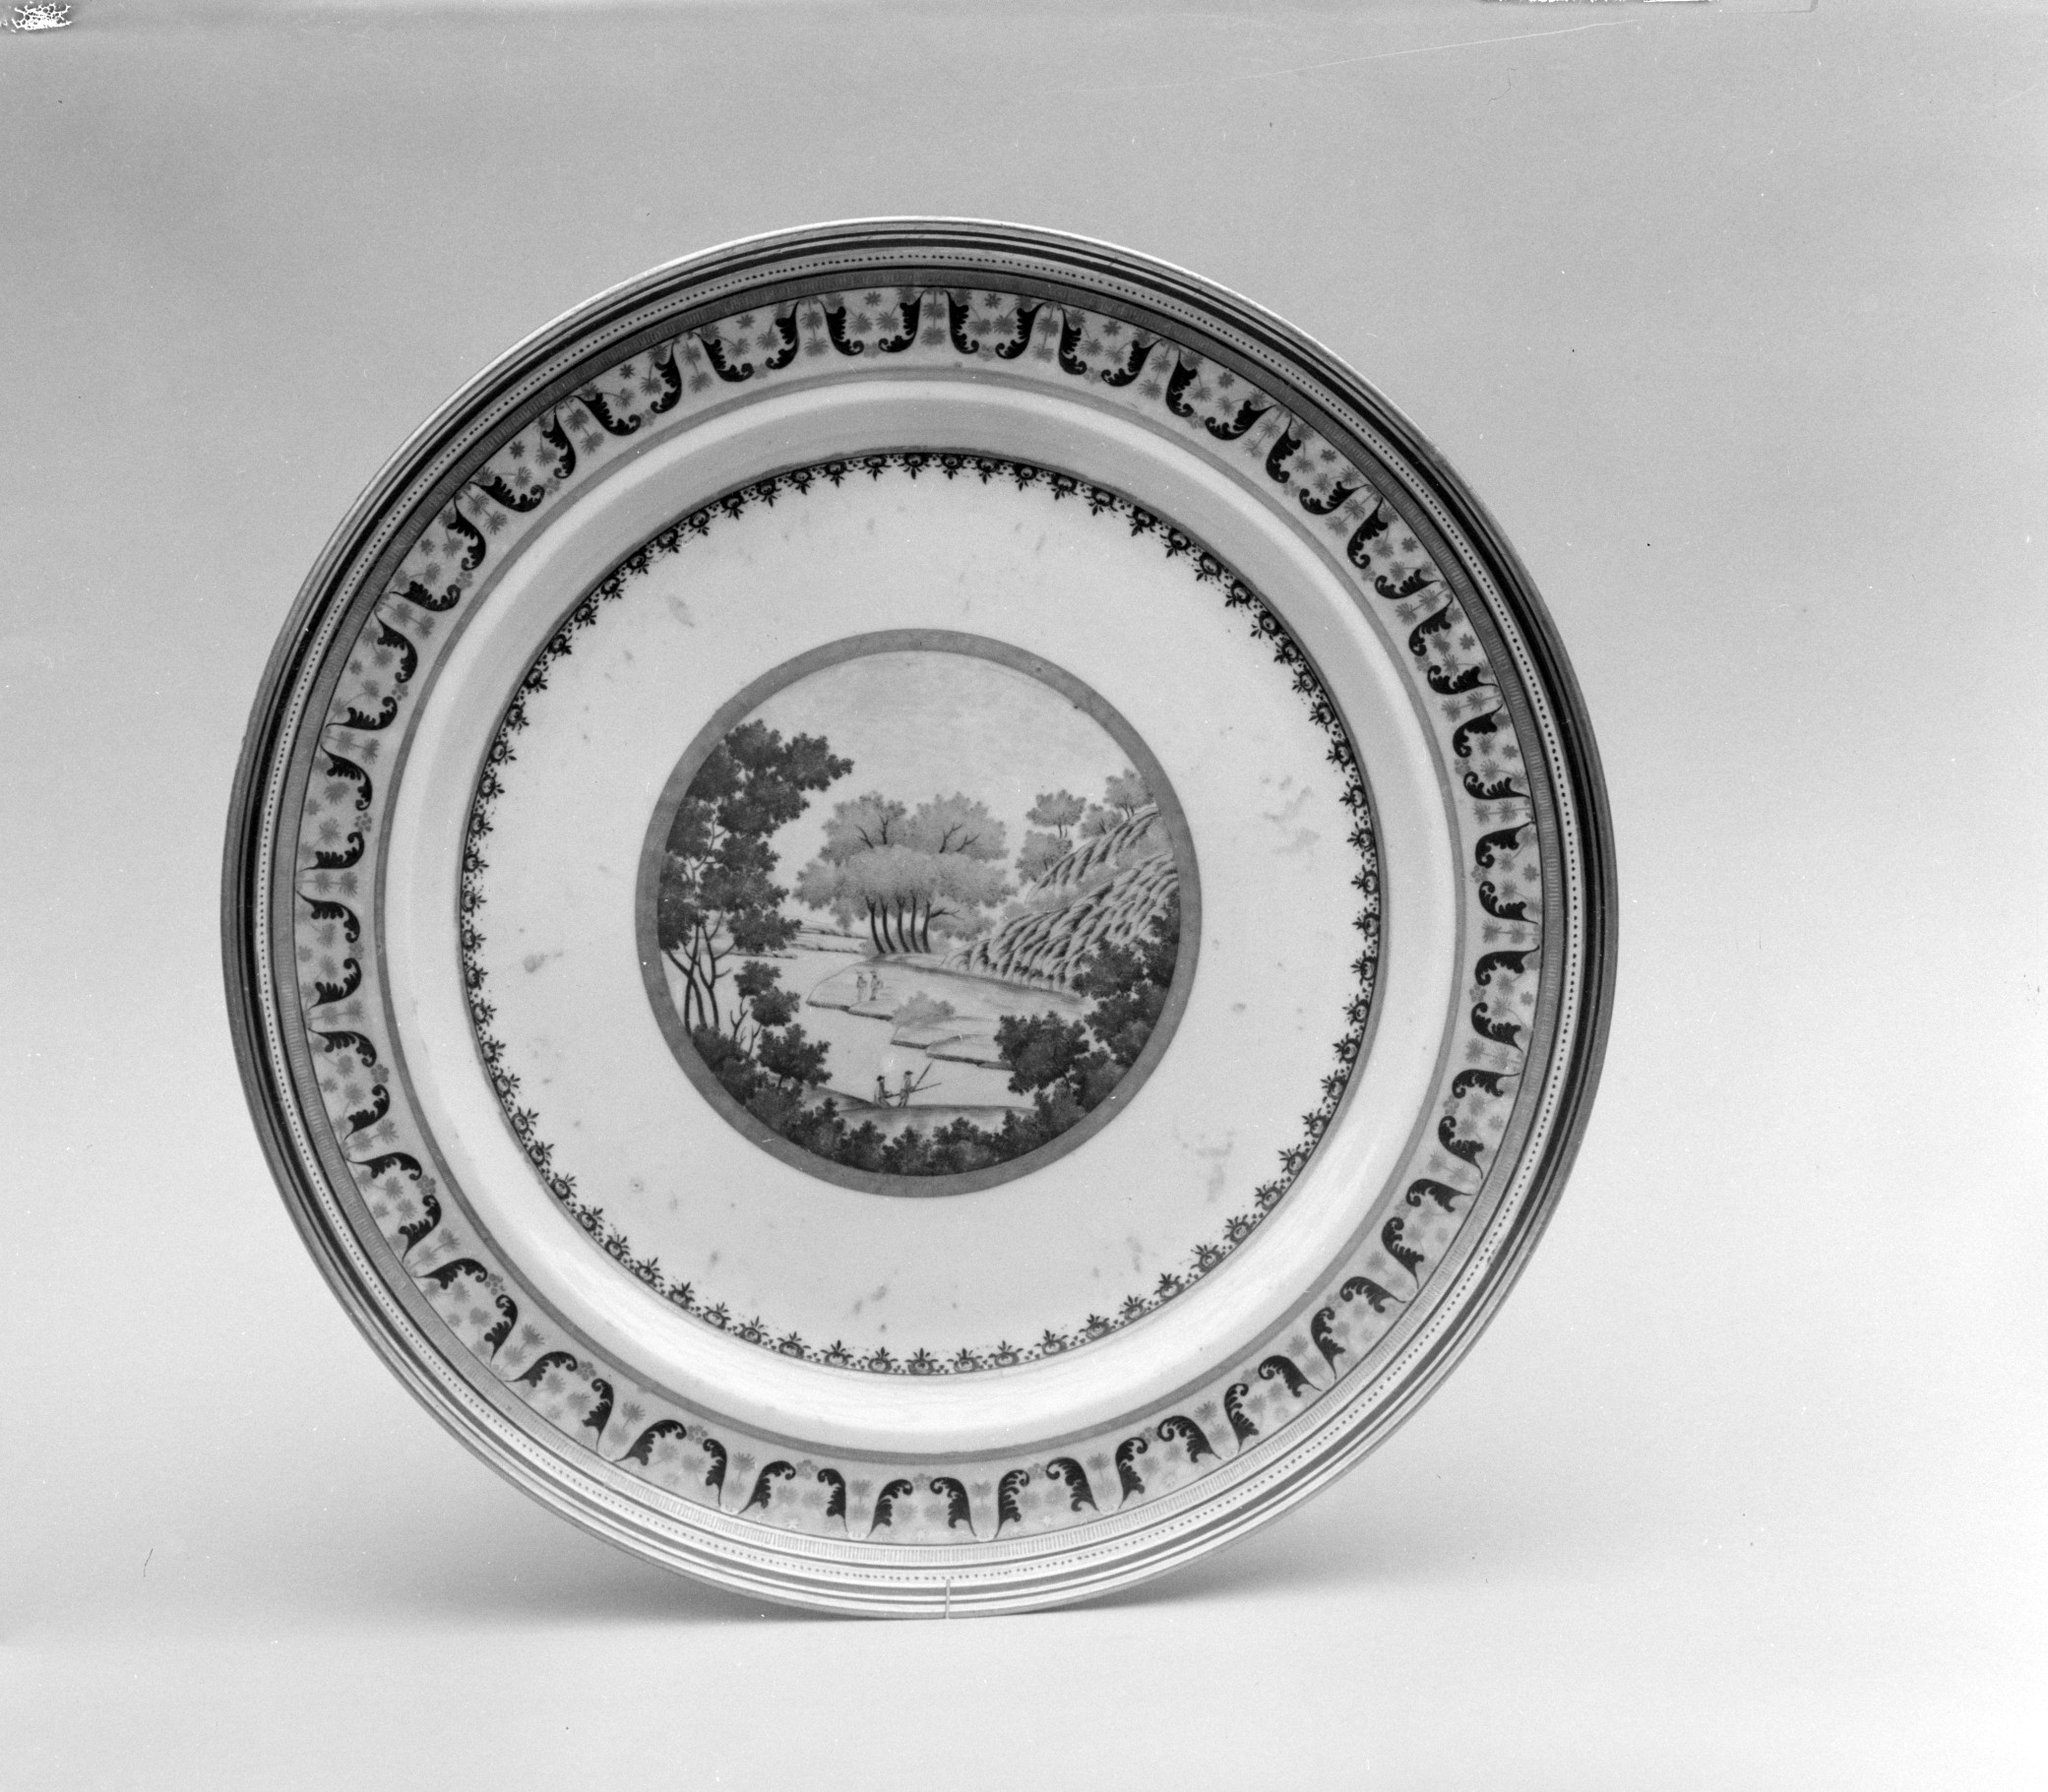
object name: plate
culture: chinese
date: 1800-1830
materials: porcelain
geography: china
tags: landscapes